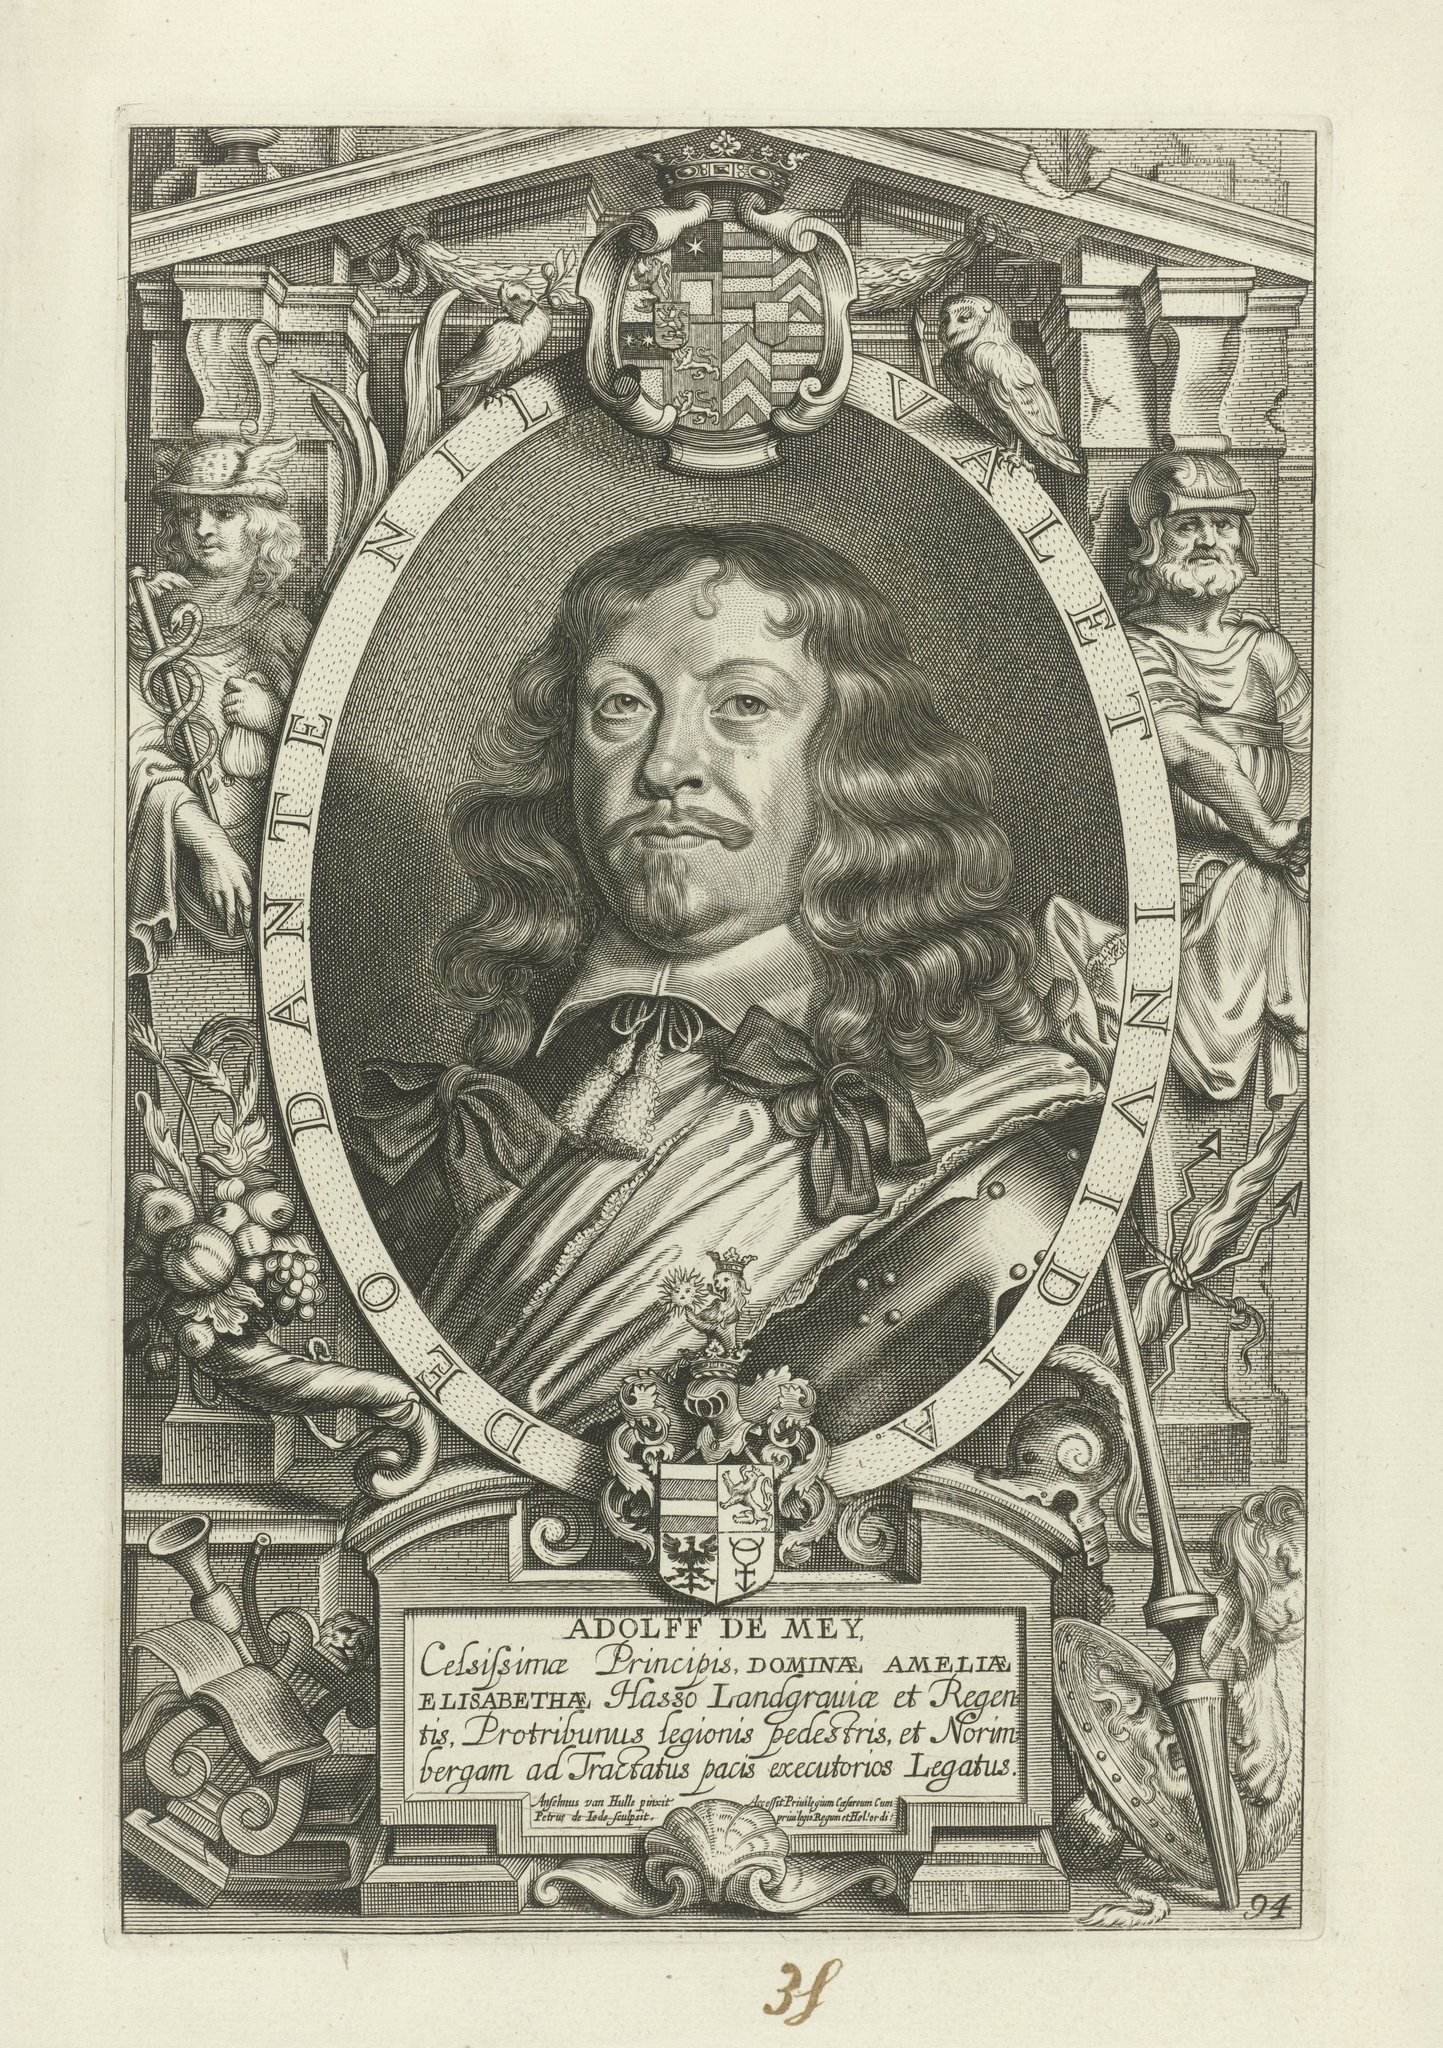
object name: print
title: Portret van Adolff de Mey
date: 1628-1670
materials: paper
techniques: engraving, etching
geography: antwerp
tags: (story of) hercules (heracles), symbols, allegories of peace, 'pax'; 'pace' (ripa), (story of) apollo (phoebus), attributes of hercules, owls, attributes of apollo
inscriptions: collector's mark: Lugt 2228, inscription: ‘3f’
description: Busteportret van Adolff de Mey. Rechtsonder: 94. Het portret is gevat in een ovale omlijsting met het wapenschild van de geportretteerde en een randschrift in het Latijn. Op de omlijsting een duif met een olijftak en een uil. De omlijsting wordt geflankeerd door standbeelden van Apollo en Hercules. Op de voorgrond hun attributen. In de cartouche een vijfregelig onderschrift in het Latijn. Prent uit een serie portretten naar schilderijen van Anselmus van Hulle van alle gedelegeerden bij de vredesonderhandelingen te Münster en Osnabrück.